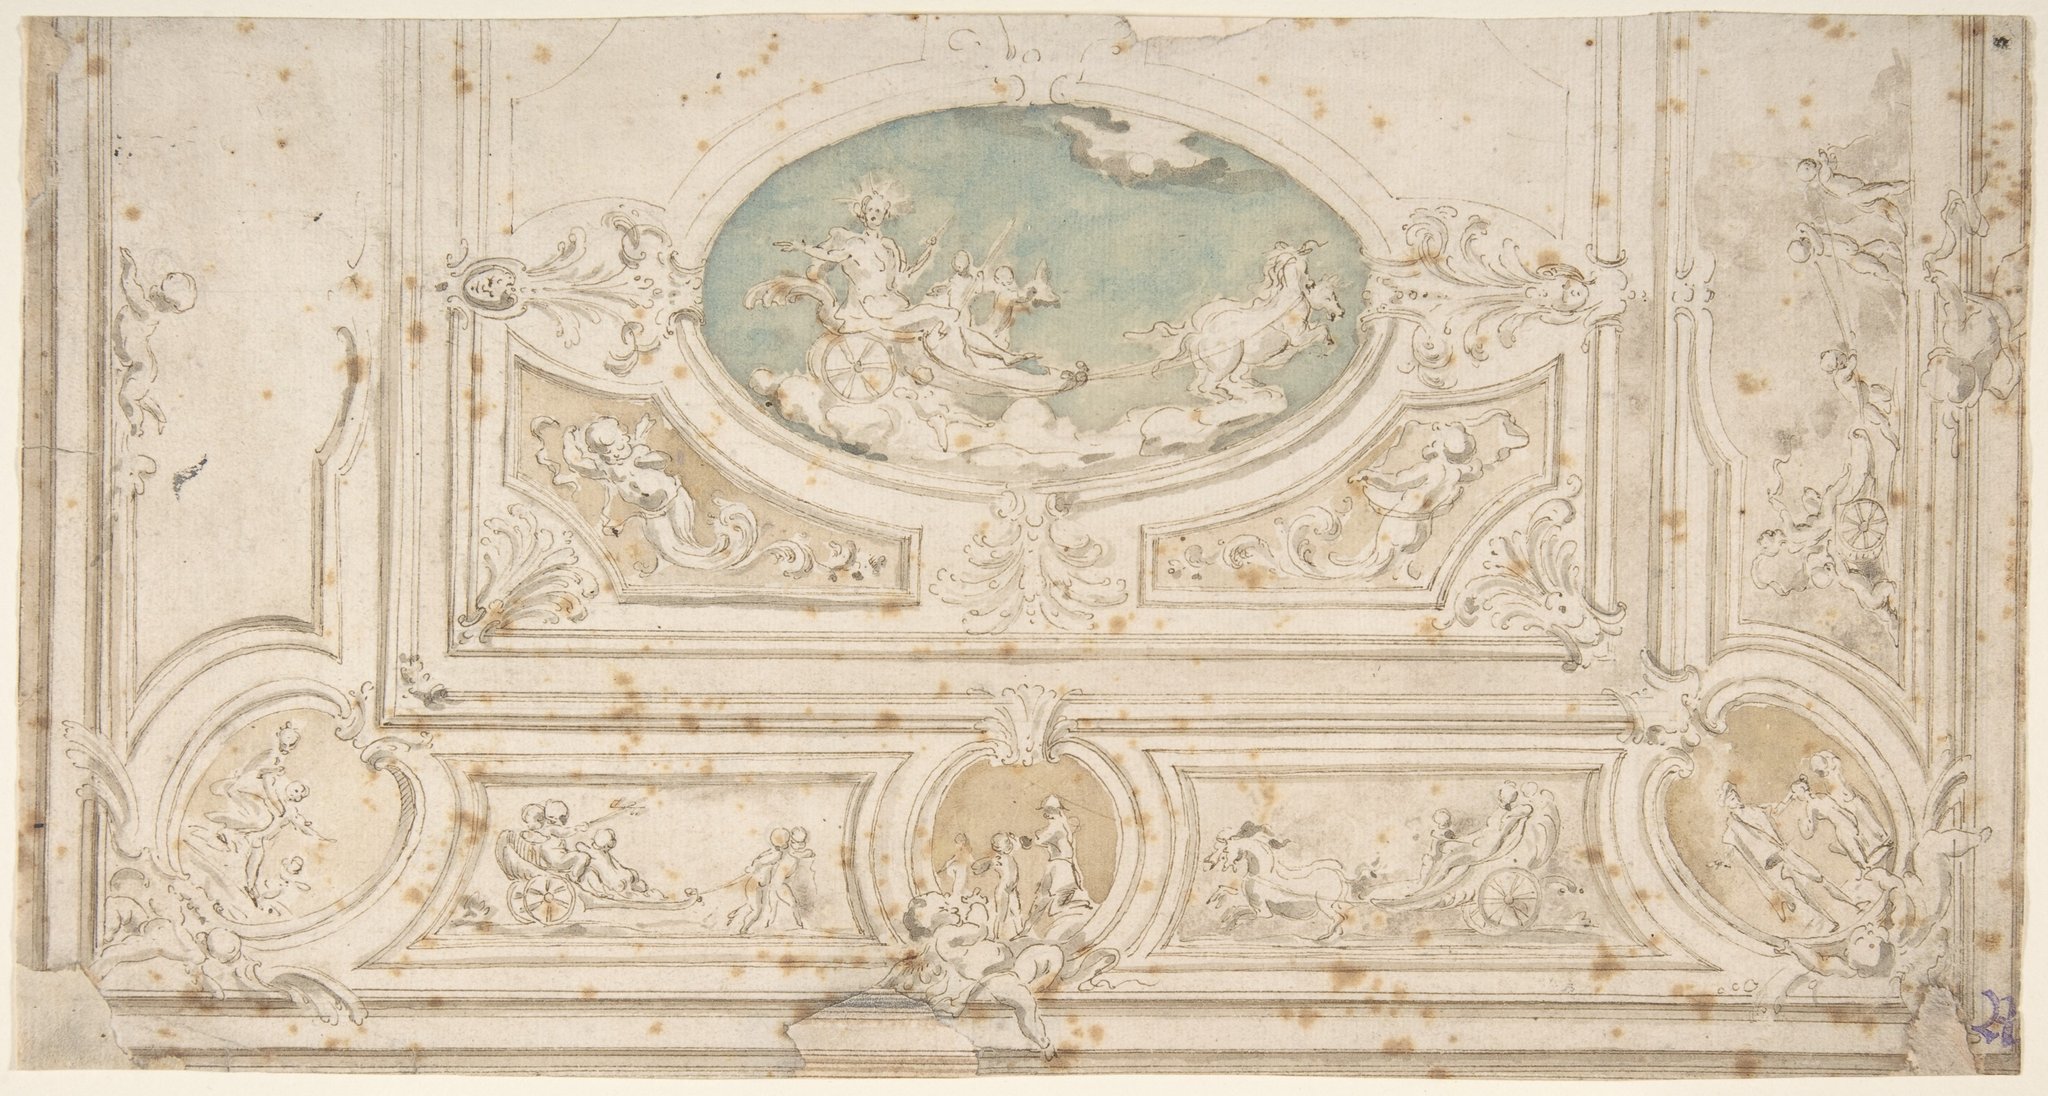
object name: drawing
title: Design for a Ceiling with Apollo on his Wagon in the Central Compartment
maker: anonymous, italian, 18th century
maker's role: artist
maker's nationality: italian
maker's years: 1700-1800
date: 1701-1800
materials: ink, watercolor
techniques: pen, wash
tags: apollo,horses,chariots